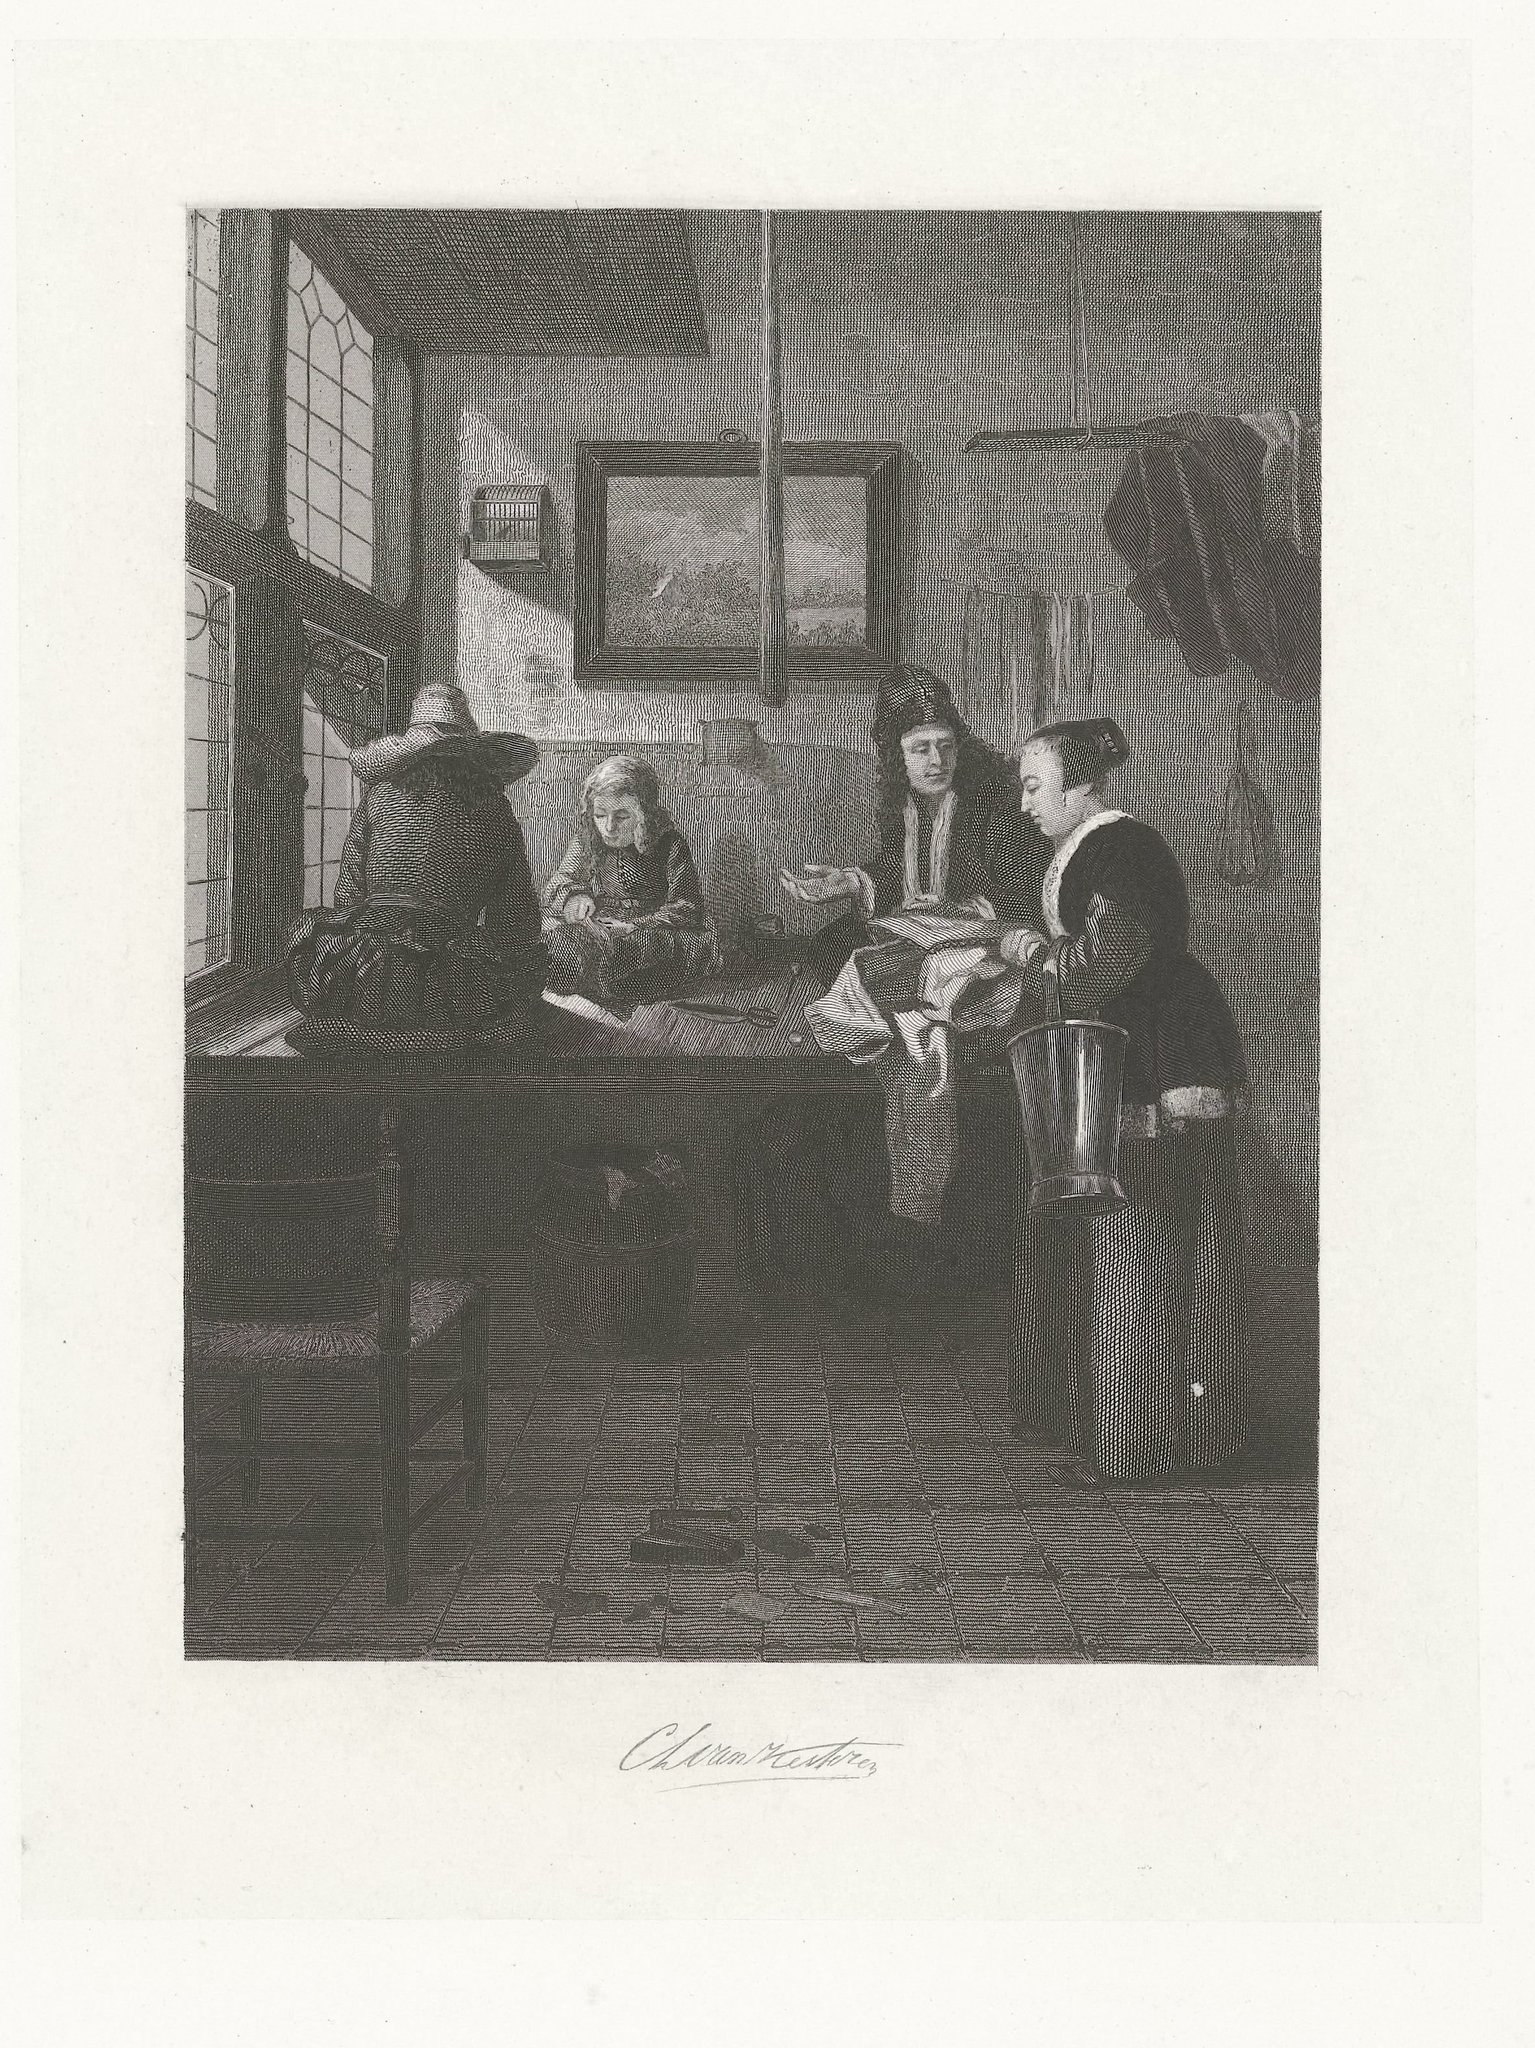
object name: print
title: Kleermakerswerkplaats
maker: christiaan lodewijk van kesteren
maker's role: print maker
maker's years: 1832-1897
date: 1861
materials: paper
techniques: engraving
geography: amsterdam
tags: tools, aids, implements ~ crafts and industries, tailor, dressmaker, bird in a cage, sewing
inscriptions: collector's mark: Lugt 2165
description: In een kleermakerswerkplaats bevinden zich een vrouw met een koperen emmer en een kleermaker met zijn twee jonge knechten, die op een tafel bij het raam zitten te naaien. Aan de muur hangen een schilderij (rivierlandschap), een speldenkussen en een vogelkooitje en op de tafel ligt een schaar.